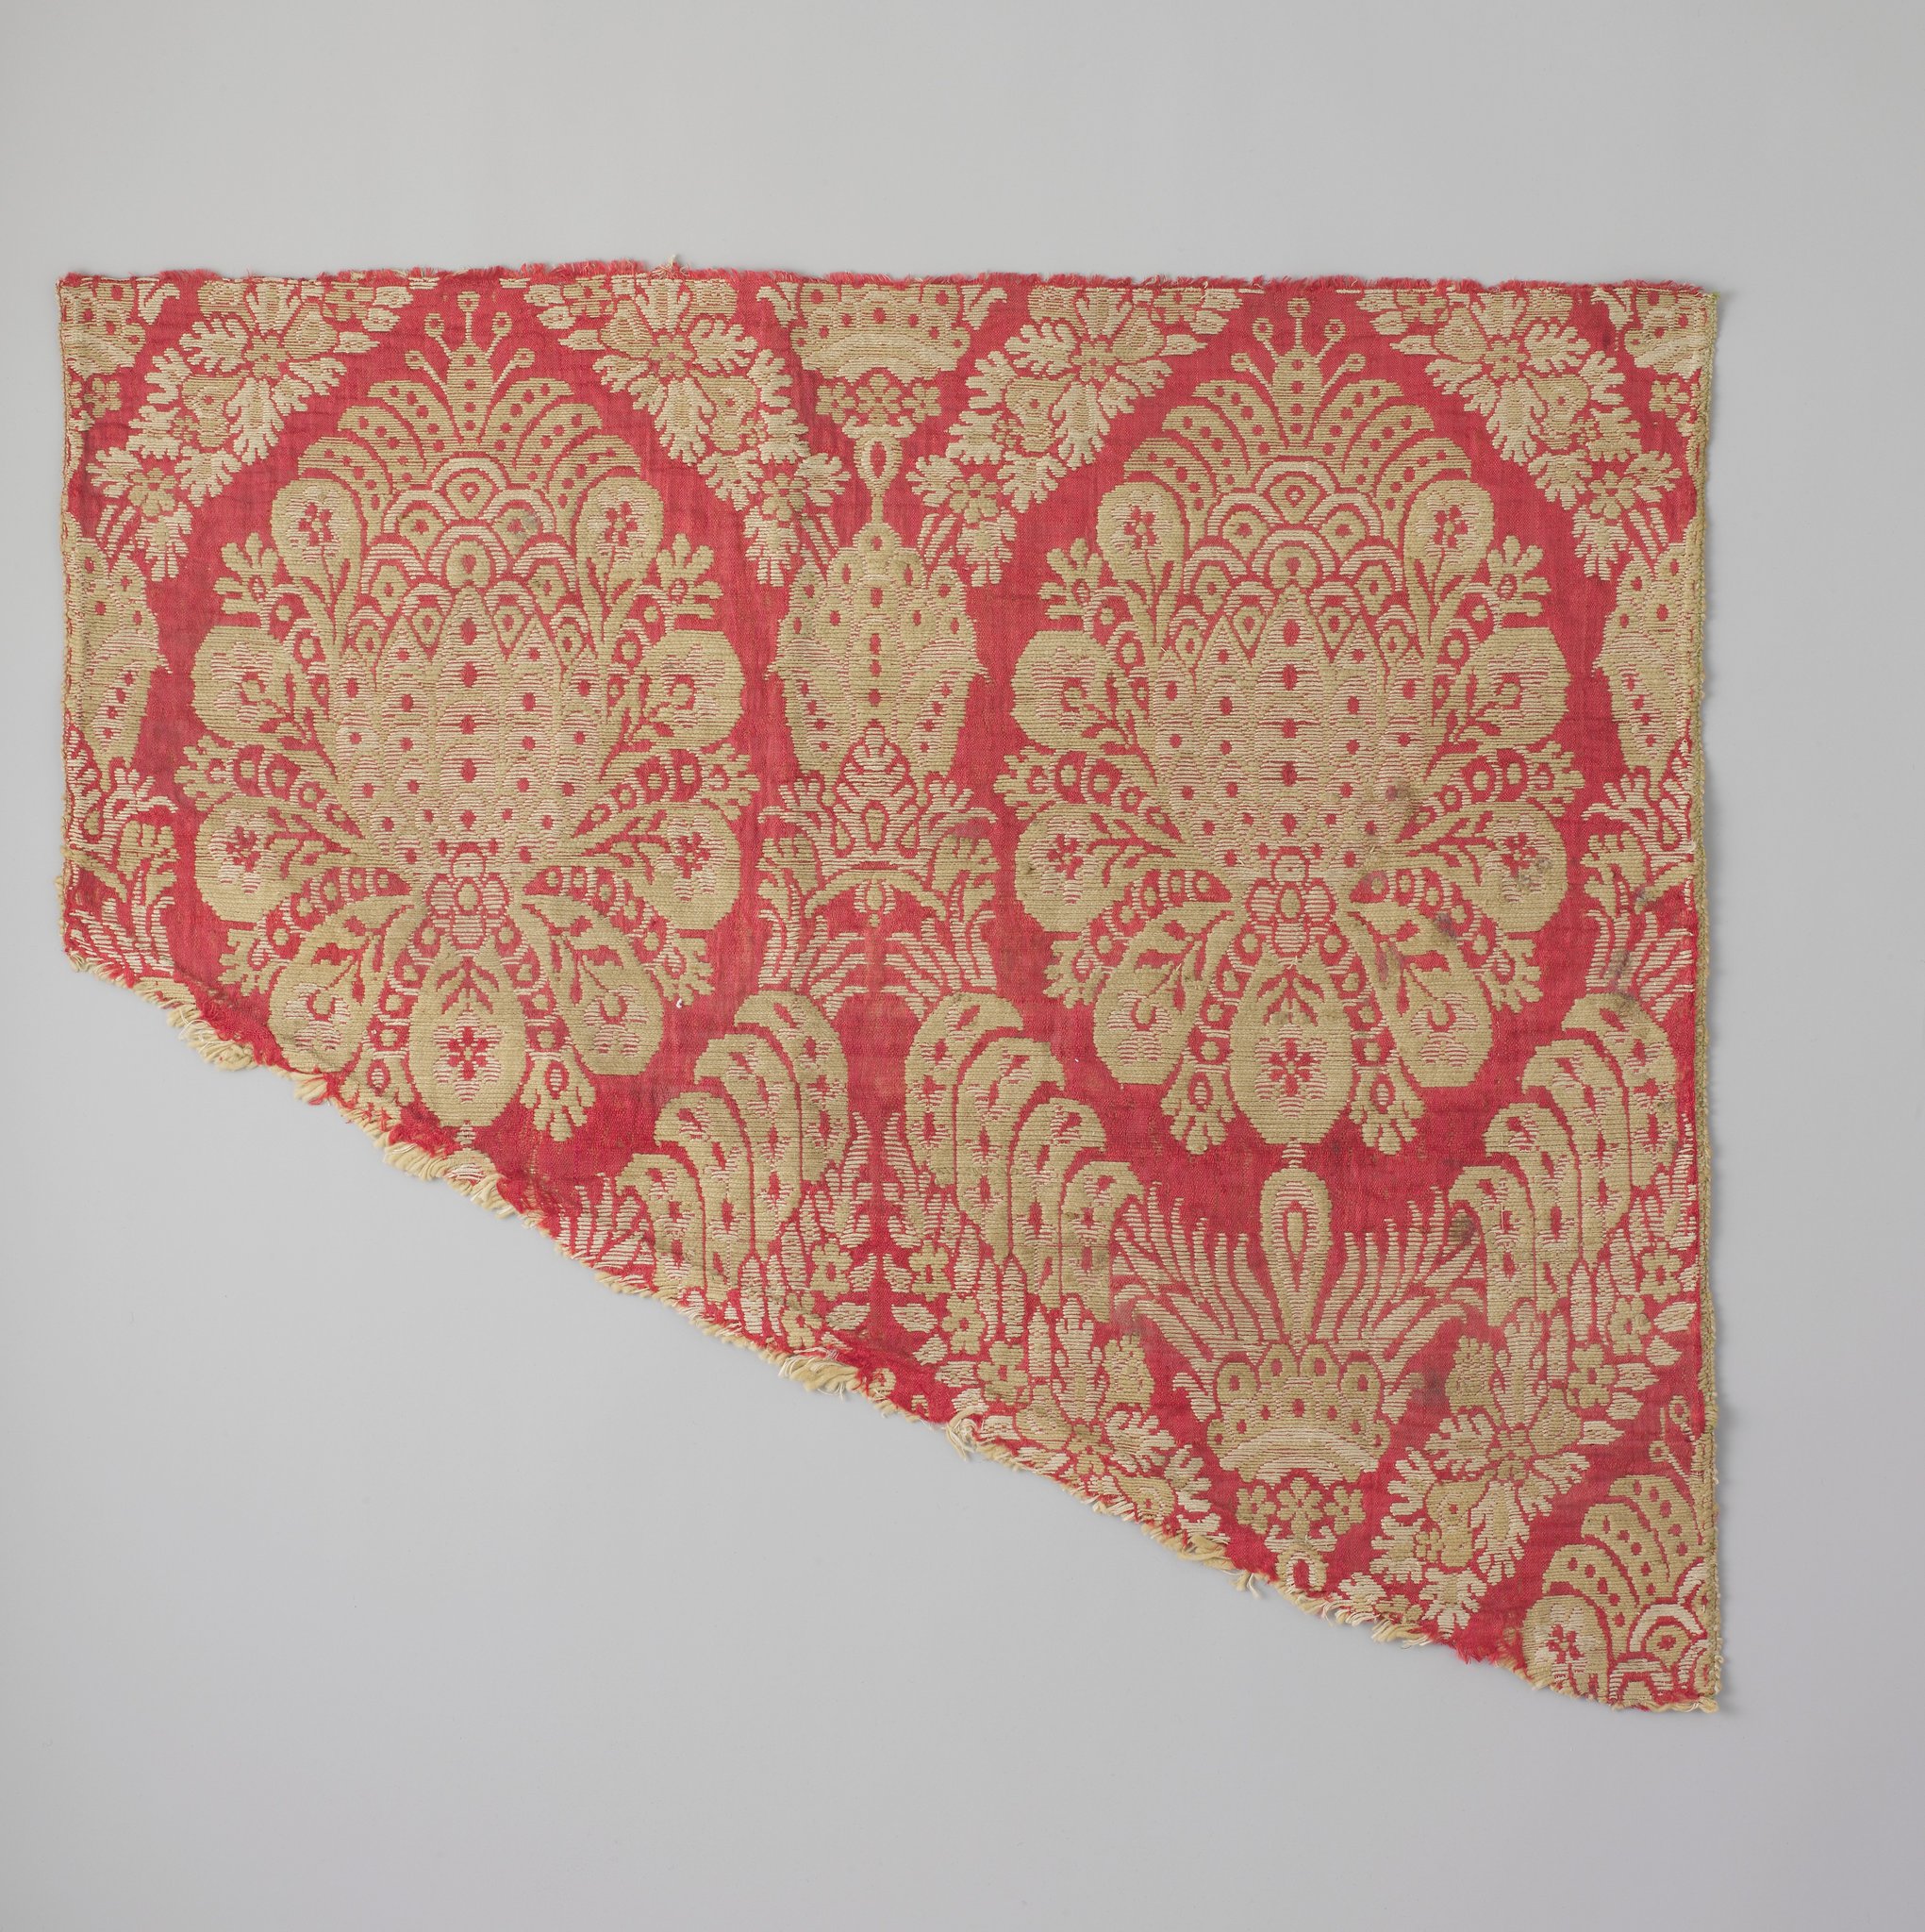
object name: piece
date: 1601-1633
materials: linen, silk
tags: leaves